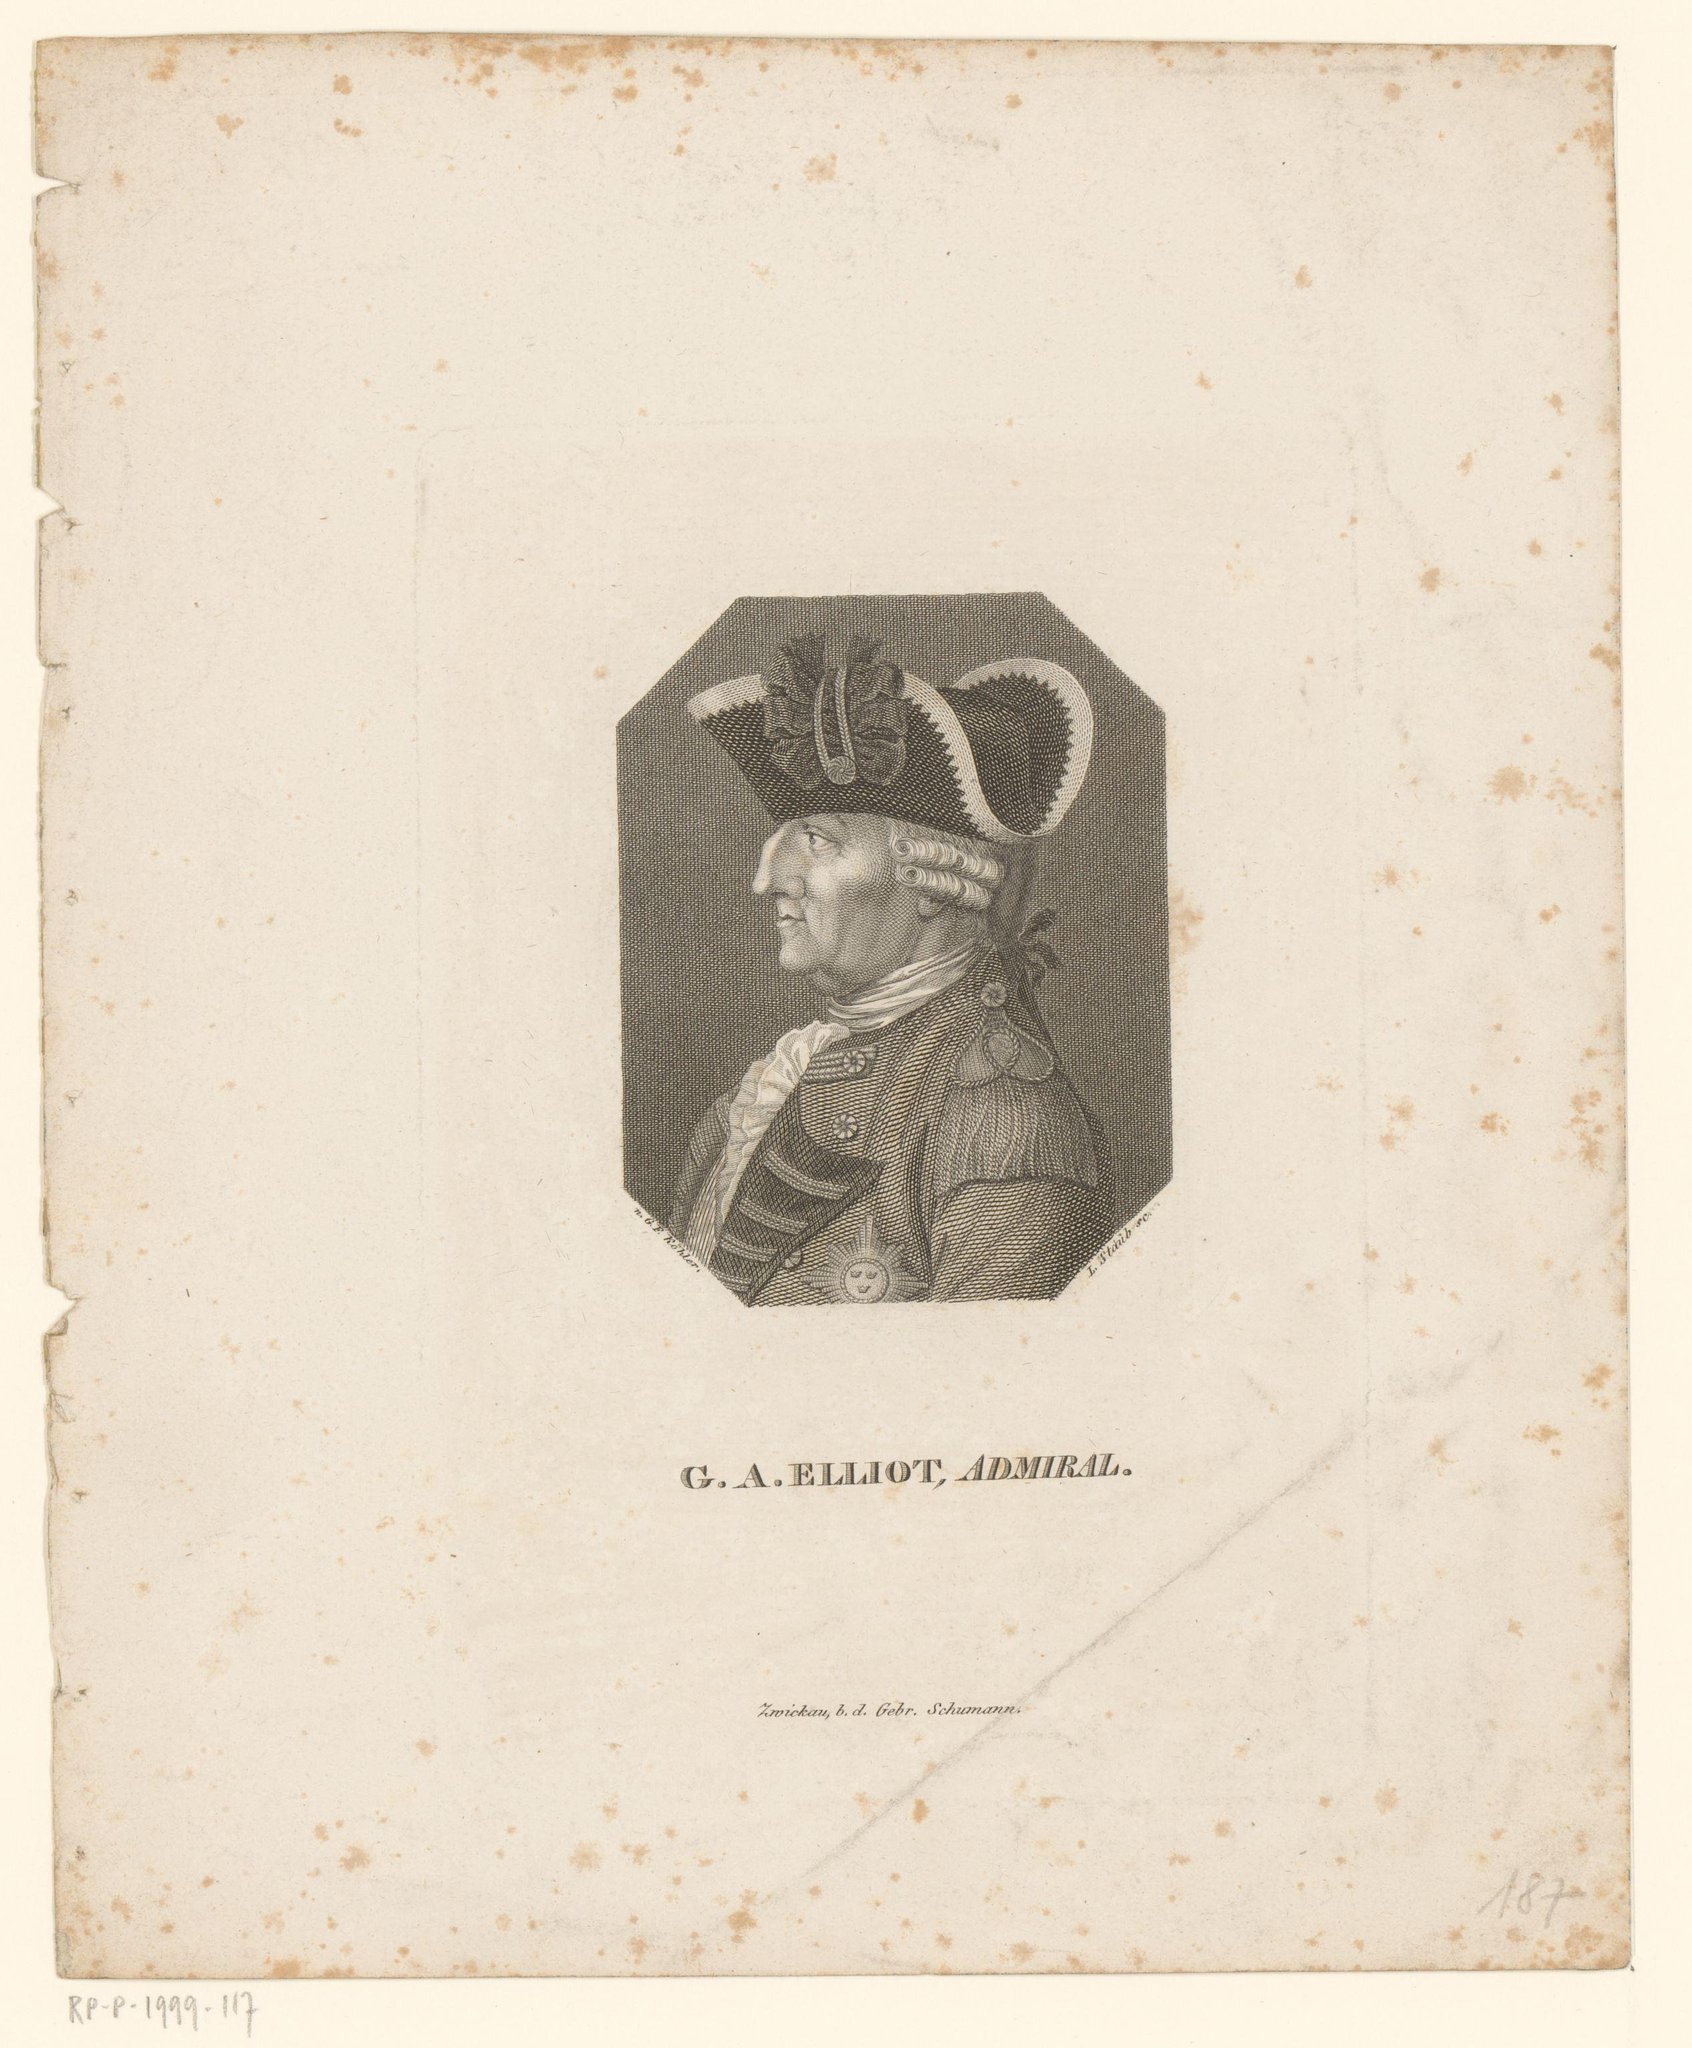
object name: print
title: Portret van George Augustus Elliot, baron Heathfield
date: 1818-1826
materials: paper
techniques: engraving, etching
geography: zwickau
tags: historical persons, commander-in-chief, admiral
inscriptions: collector's mark: Lugt 2228, number: ‘187’, collector's mark: Lugt 2760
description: Prent gebruikt door de serie 'Bildnisse der berühmtesten Menschen aller Völker und Zeiten', uitgegeven door de gebroeders Schumann in 1818-1832 te Zwickau.